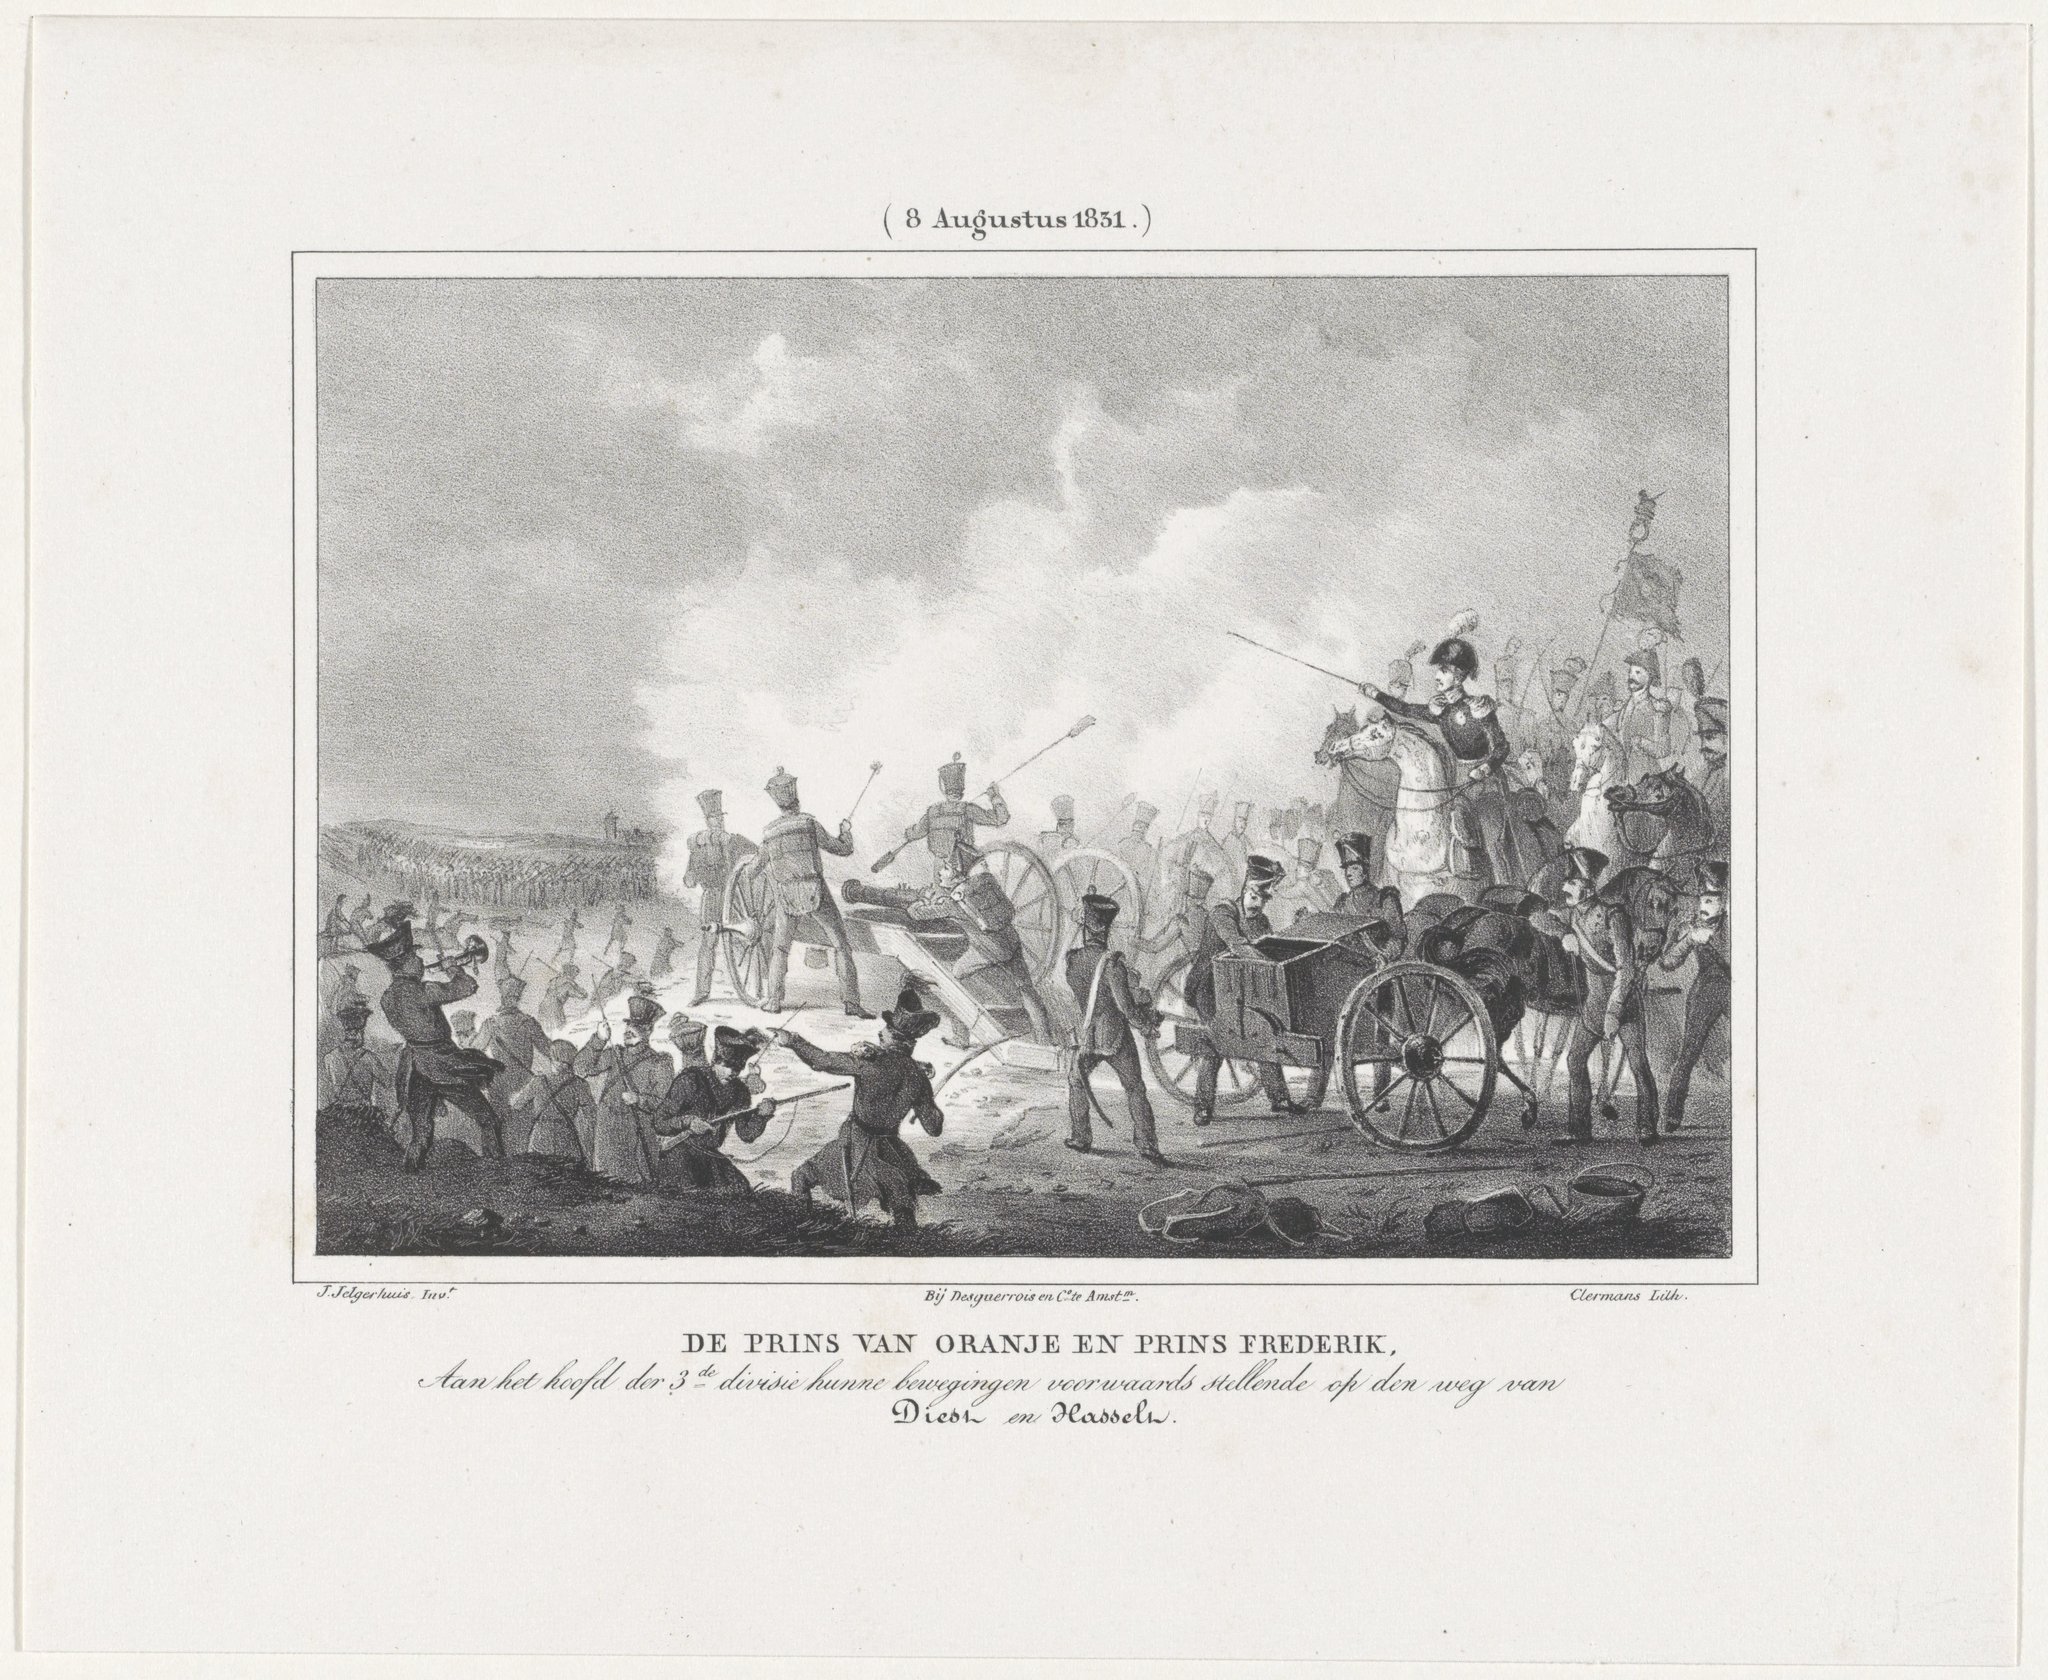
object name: print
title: De Prins van Oranje en prins Frederik leiden de Nederlandse troepen, 1831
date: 1831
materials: paper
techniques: lithograph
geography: netherlands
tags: the hague, william ii of the netherlands, frederik (prins der nederlanden), battle (+ land forces)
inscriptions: collector's mark: Lugt 2228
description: De prins van Oranje en prins Frederik leiden de Nederlandse troepen bij de weg tussen Diest en Hasselt op 8 augustus 1831. Onderdeel van een serie van zeven platen.